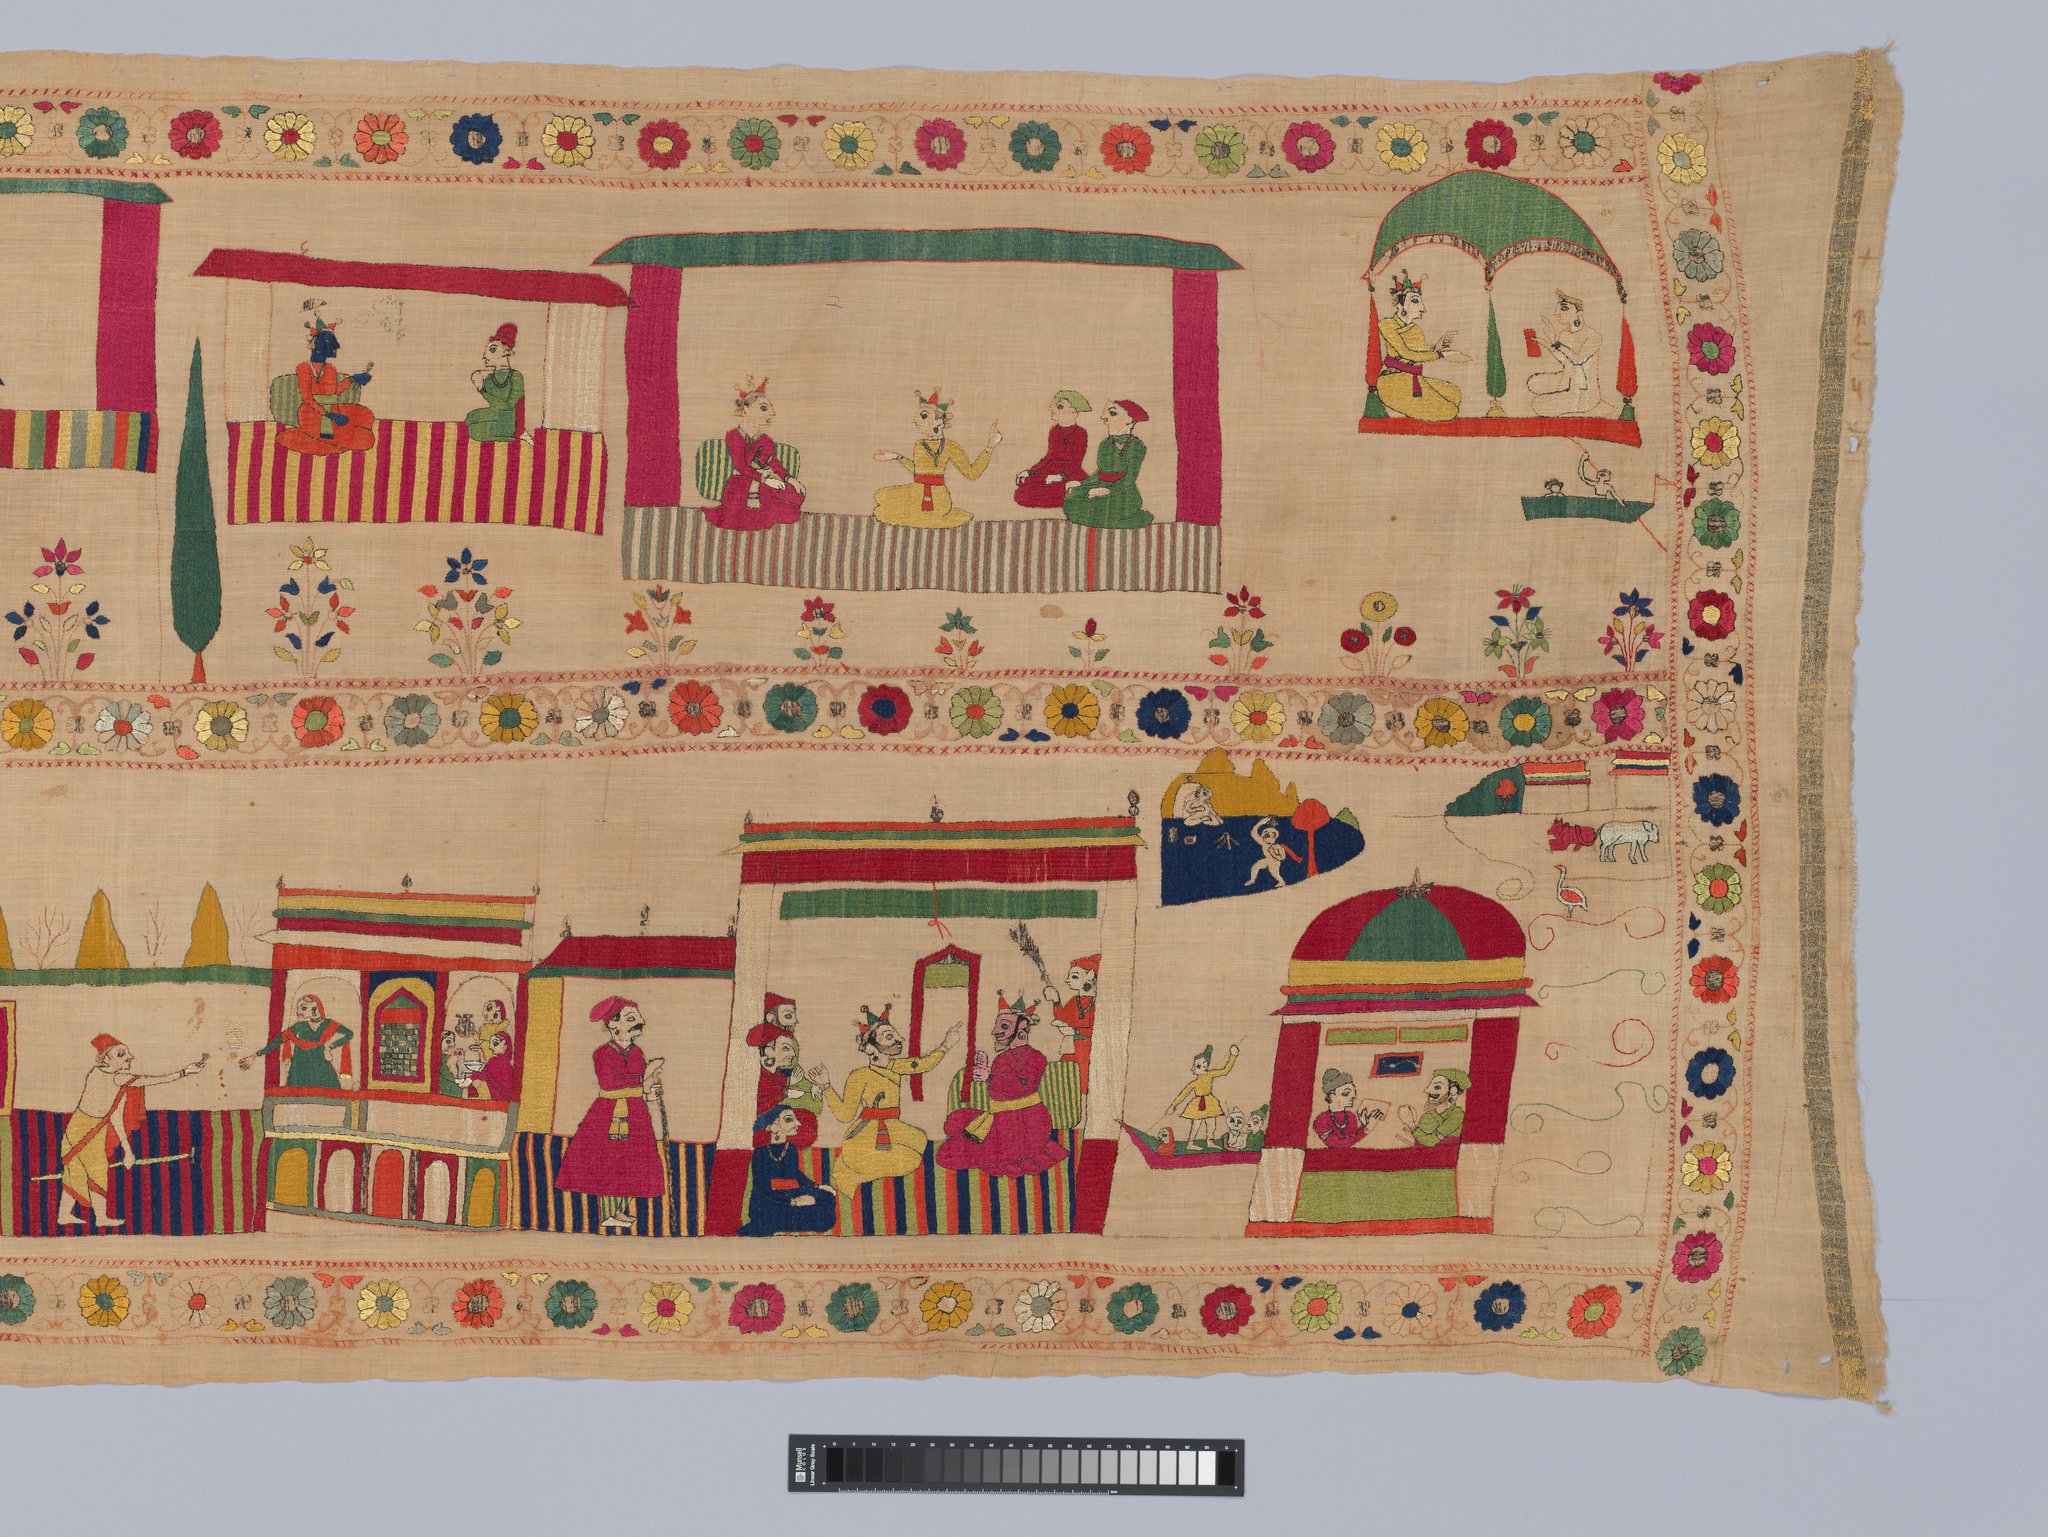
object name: cover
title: Festival Banner Showing Krishna Rescuing and Marrying Rukmini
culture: indian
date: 1800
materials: cotton, metal thread, silk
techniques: dyeing, embroidery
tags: men,elephants,horses,krishna,boats